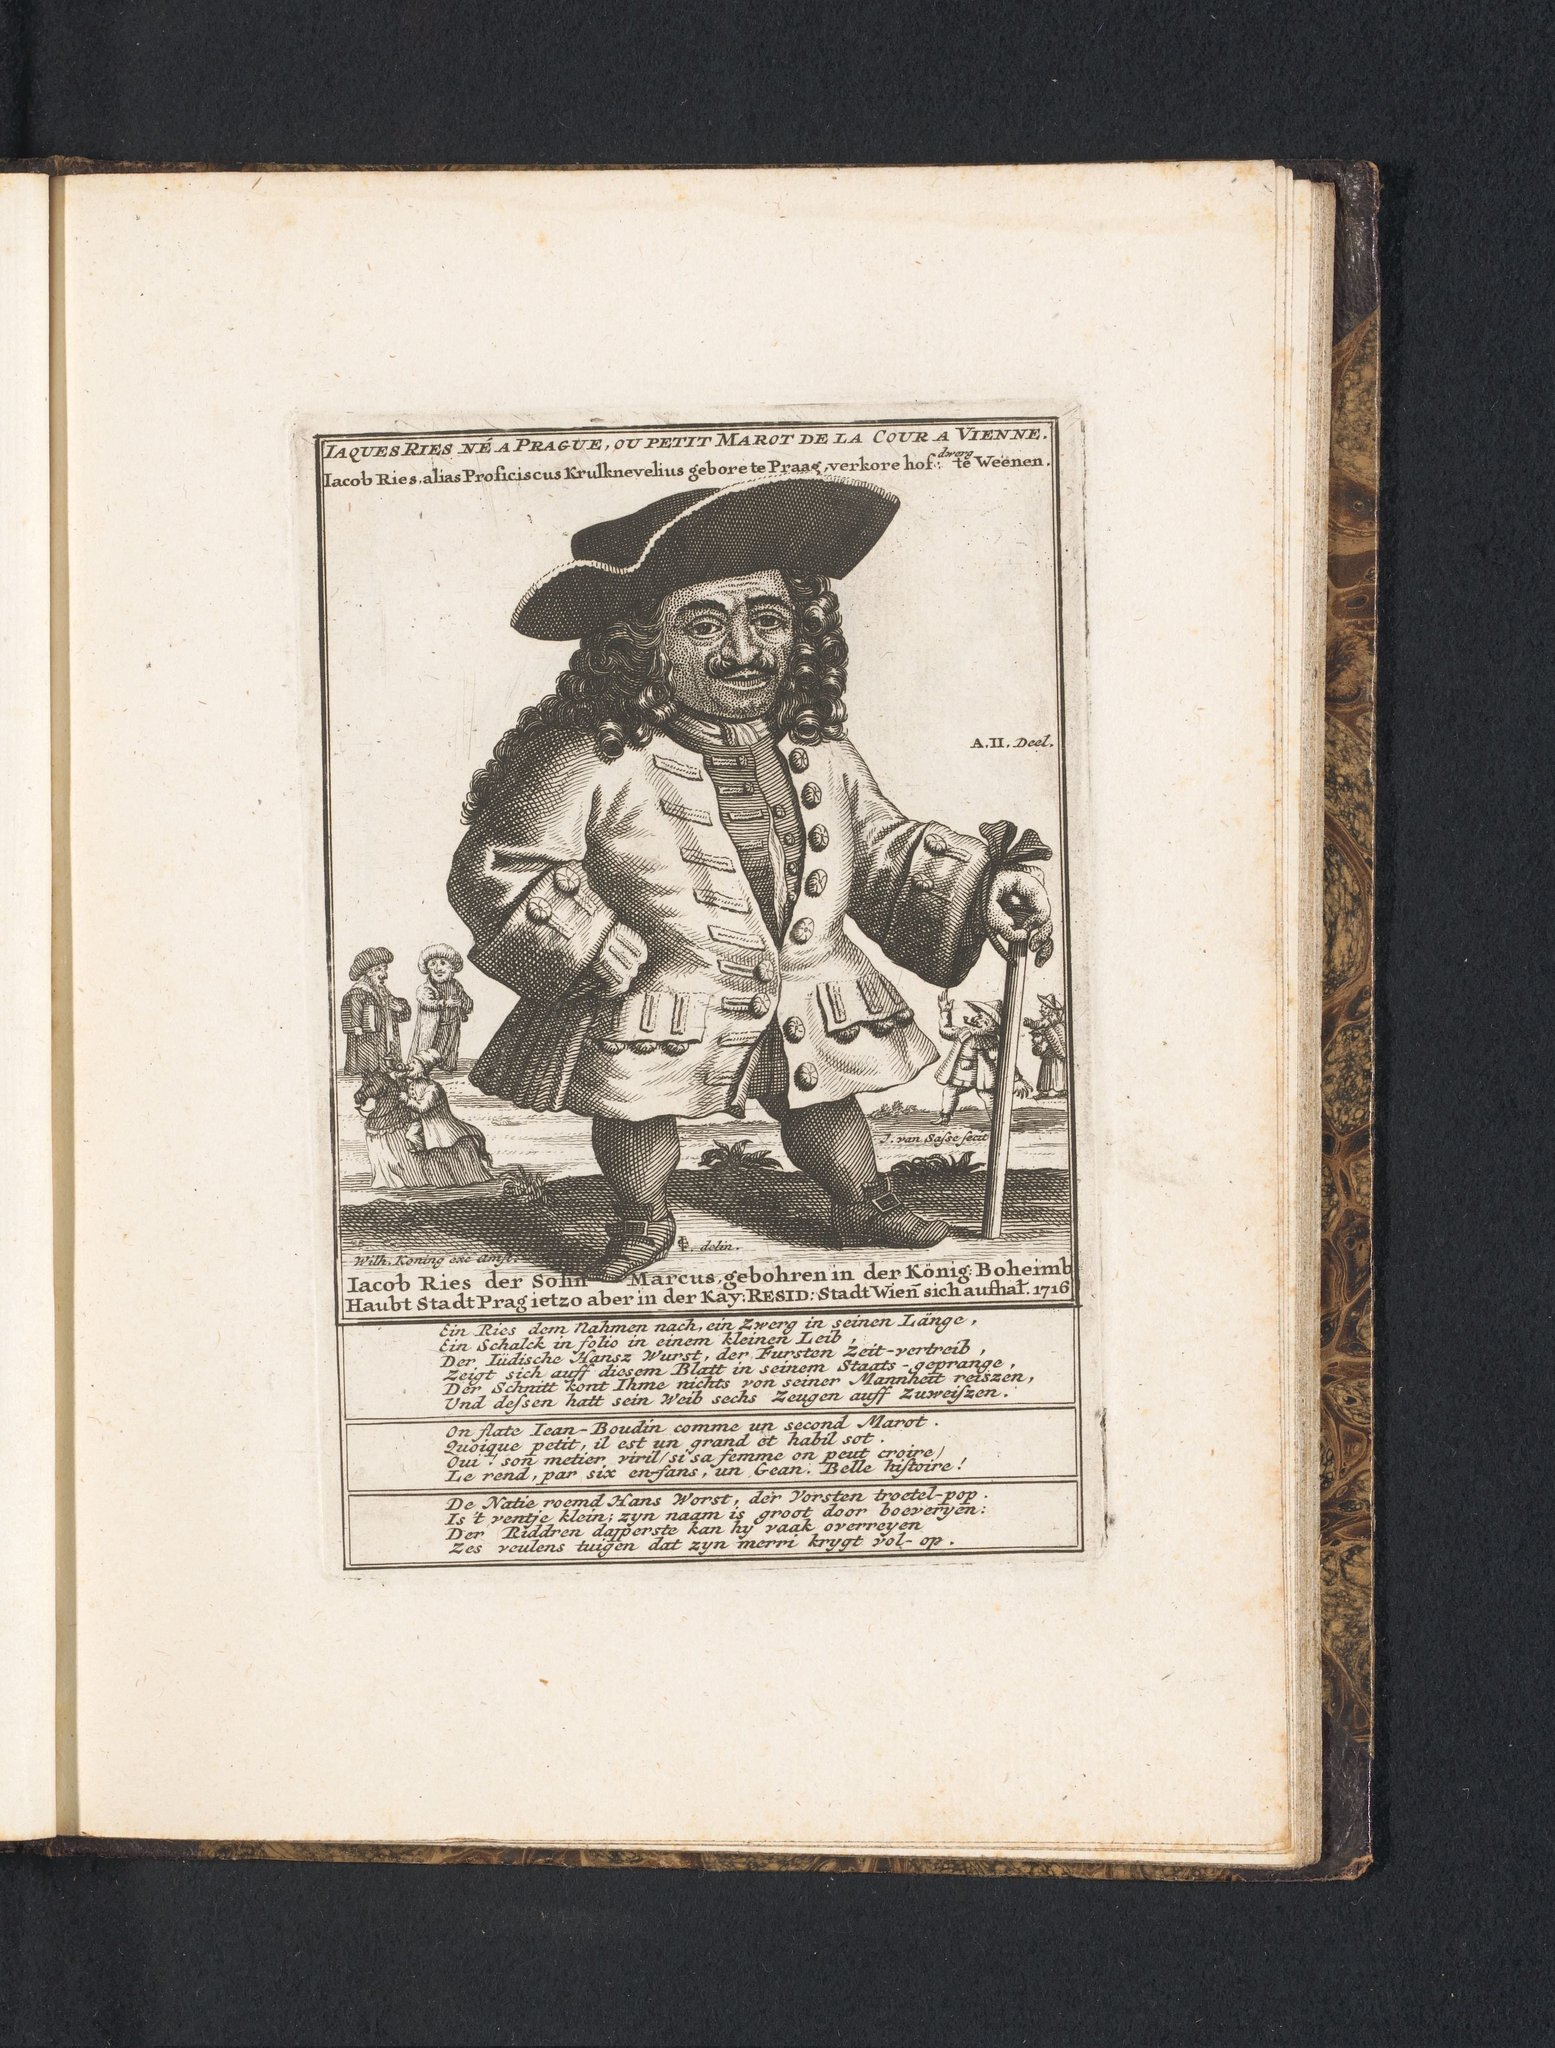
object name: print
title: De dwerg Jacob Ries, 1720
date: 1718-1720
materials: paper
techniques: etching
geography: amsterdam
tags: prague, little people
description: Portret van de Joodse kleine mens Jacob Ries, geboren te Praag, verbonden aan het keizerlijke hof te Wenen. In het onderschrift verzen in het Duits, Frans en Nederlands. Genummerd rechts midden: A. II. Onderdeel van deel II in de tweede Nederlandse gebonden uitgave uit 1720 (en gerelateerd aan de Windhandel in dat jaar) van een serie karikaturen van kleine mensen, bekend als Het Dwergentooneel.